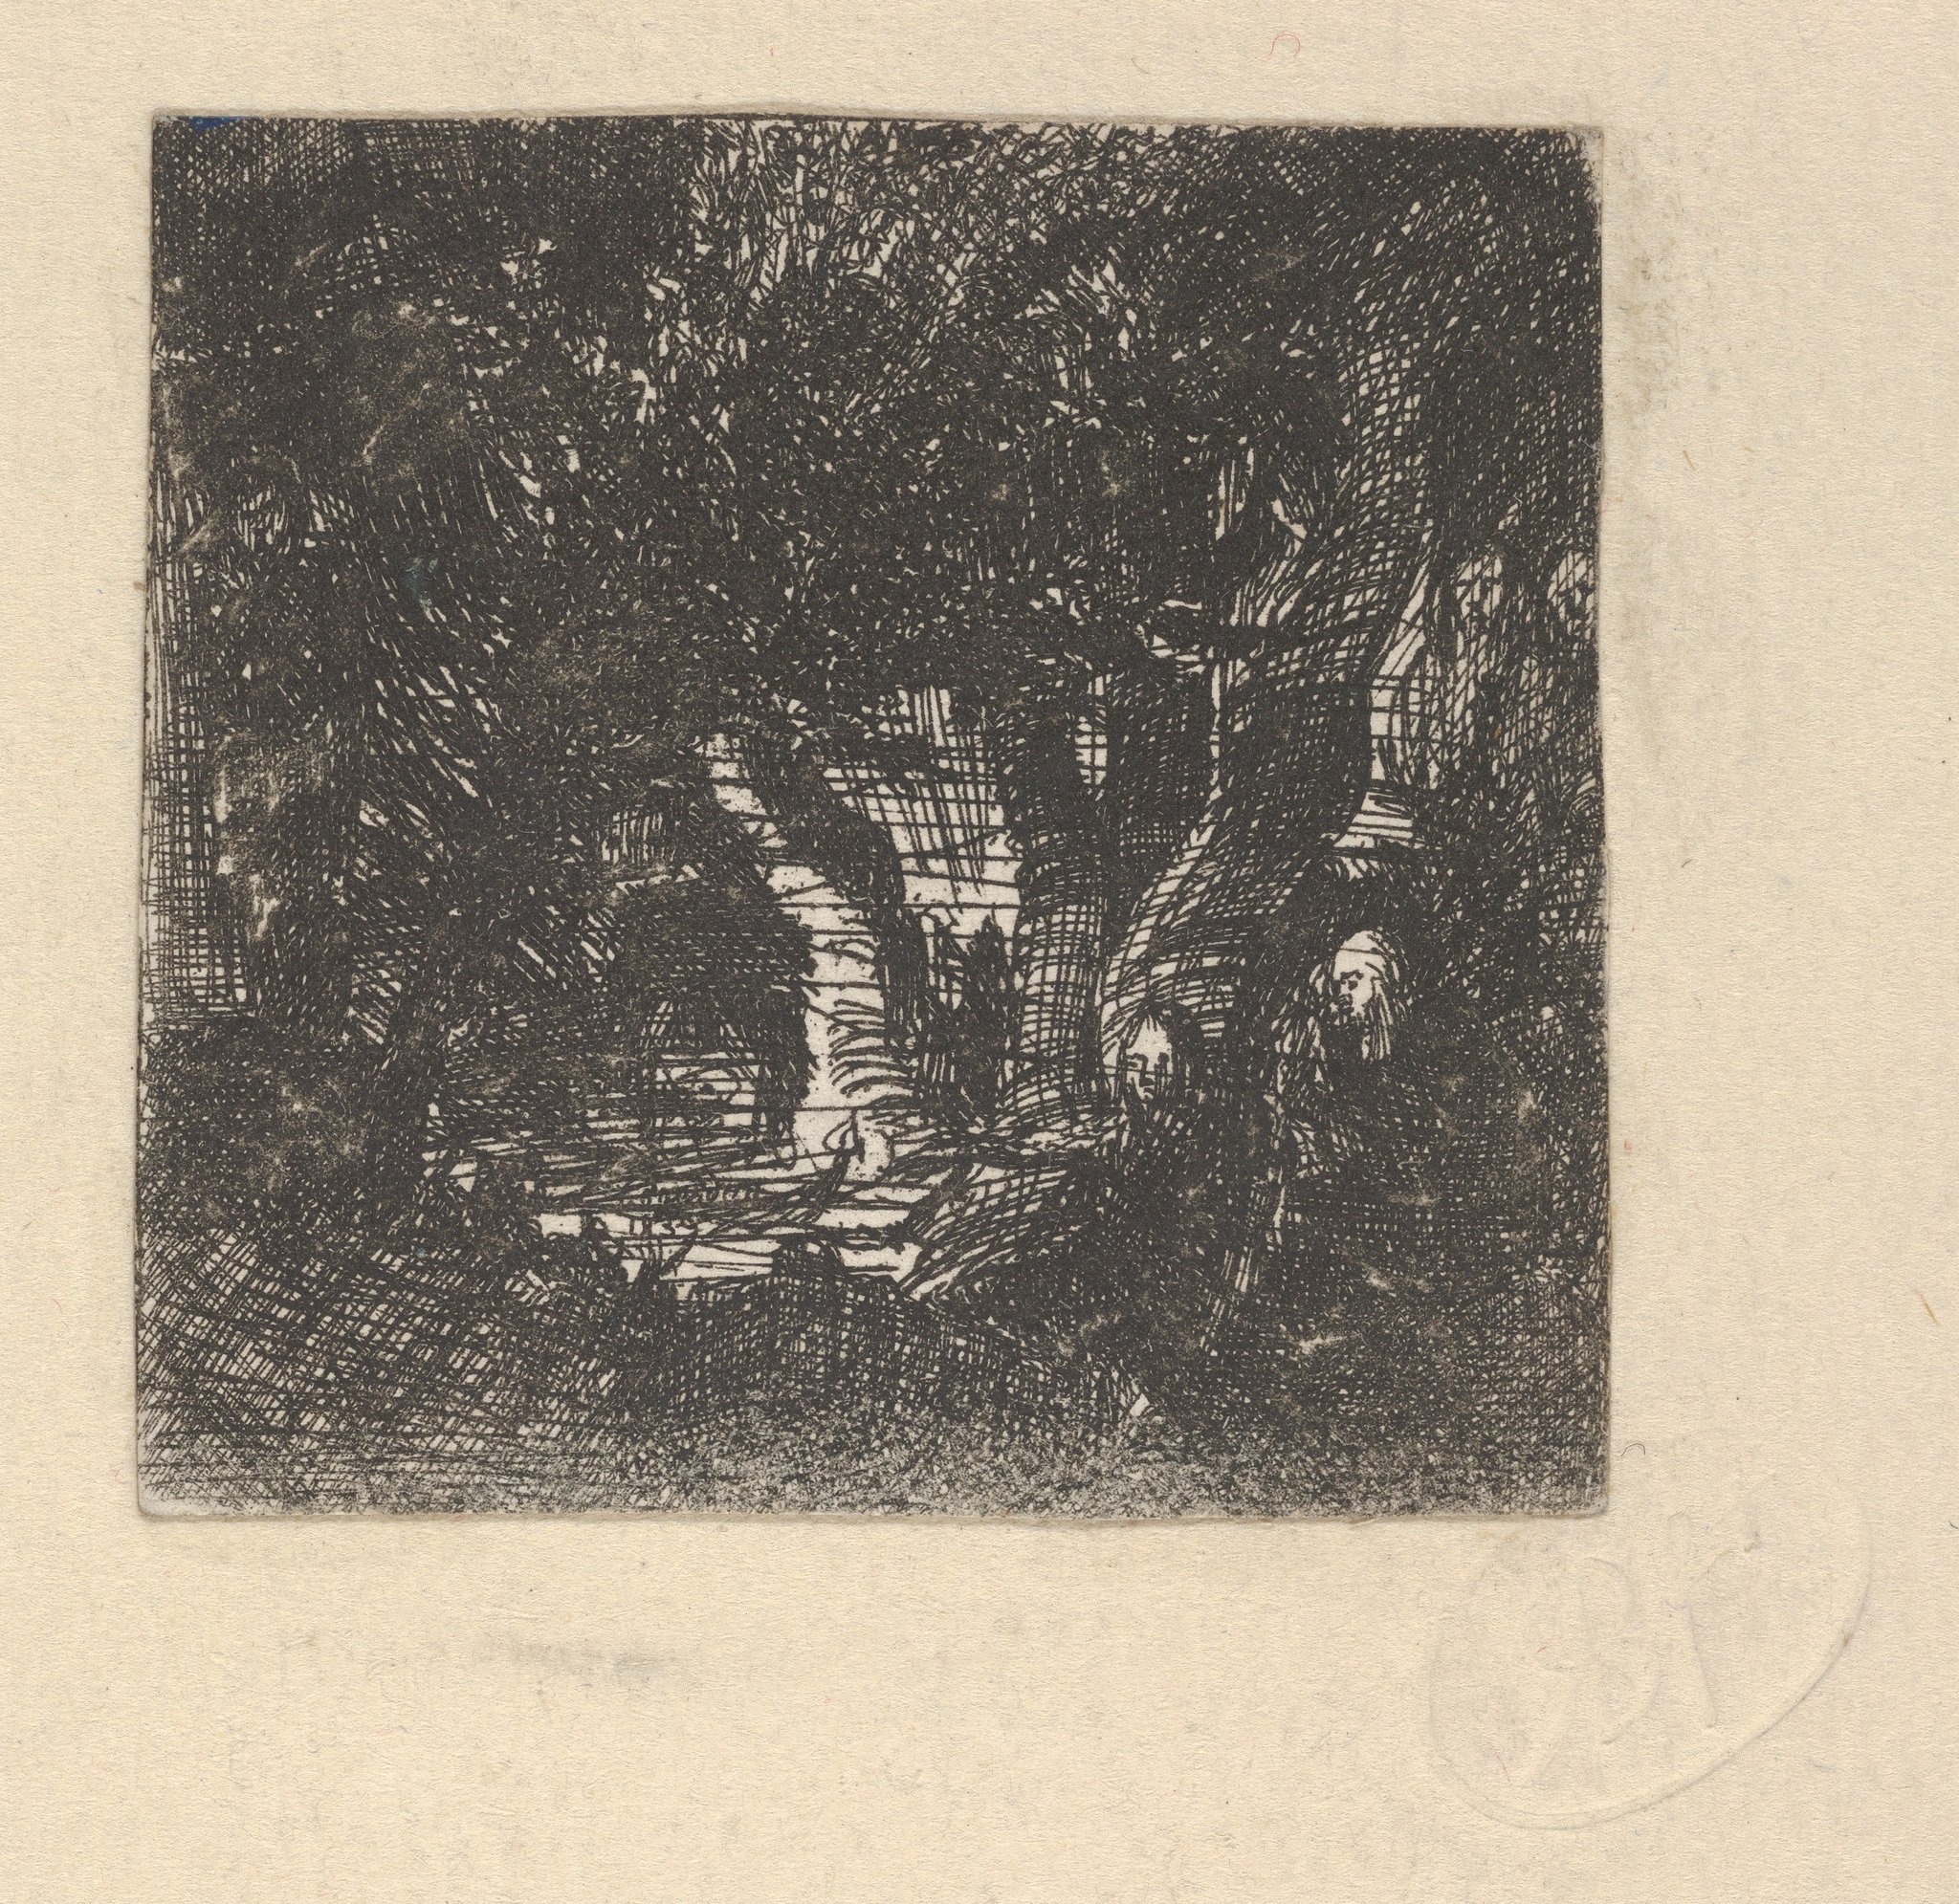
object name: print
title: La Sainte Famille et Les Bergers (The Holy Family and the Shepherds)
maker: rodolphe bresdin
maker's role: artist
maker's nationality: french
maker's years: 1822-1885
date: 1839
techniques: etching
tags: holy family,shepherds